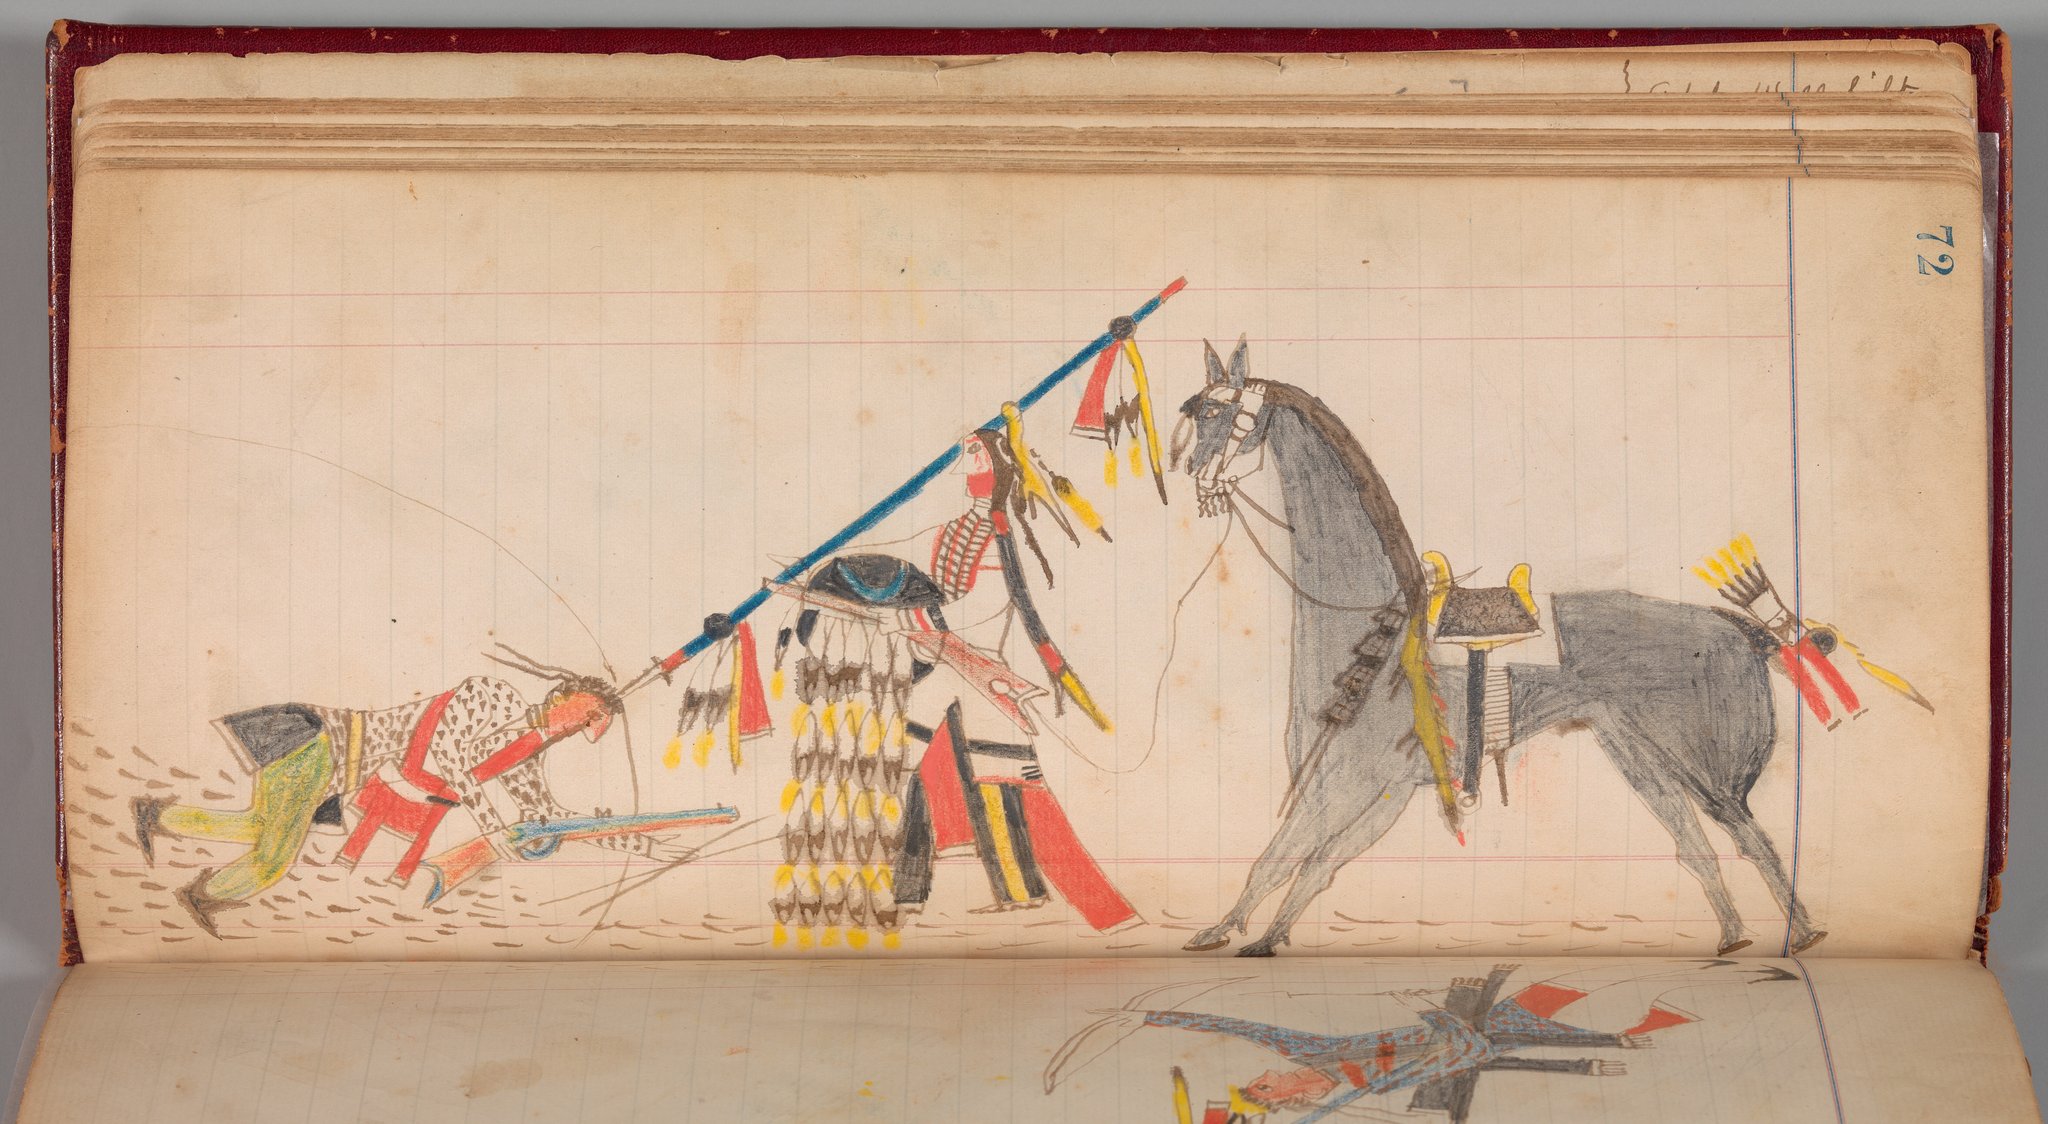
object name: drawing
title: Maffet Ledger: Drawing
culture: cheyenne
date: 1874-1881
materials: crayon, graphite, paper, watercolor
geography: united states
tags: soldiers,firearms,horses